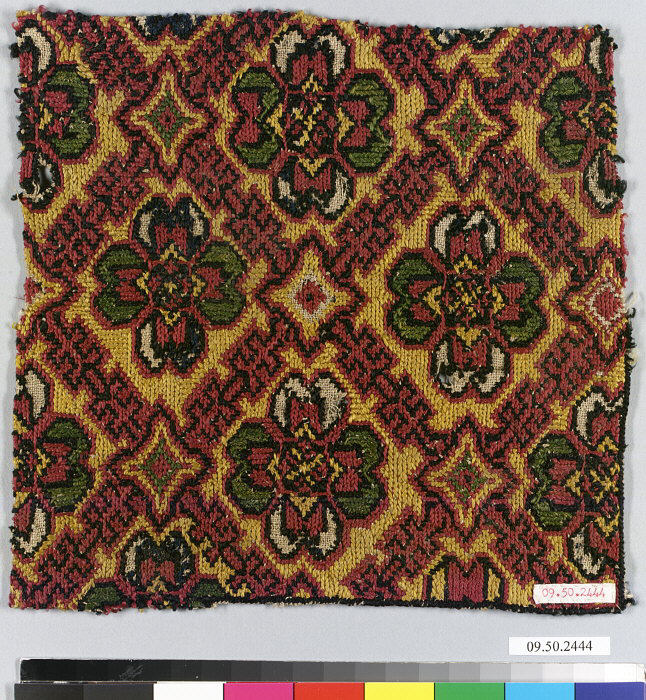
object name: fragment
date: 1801-1833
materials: canvas